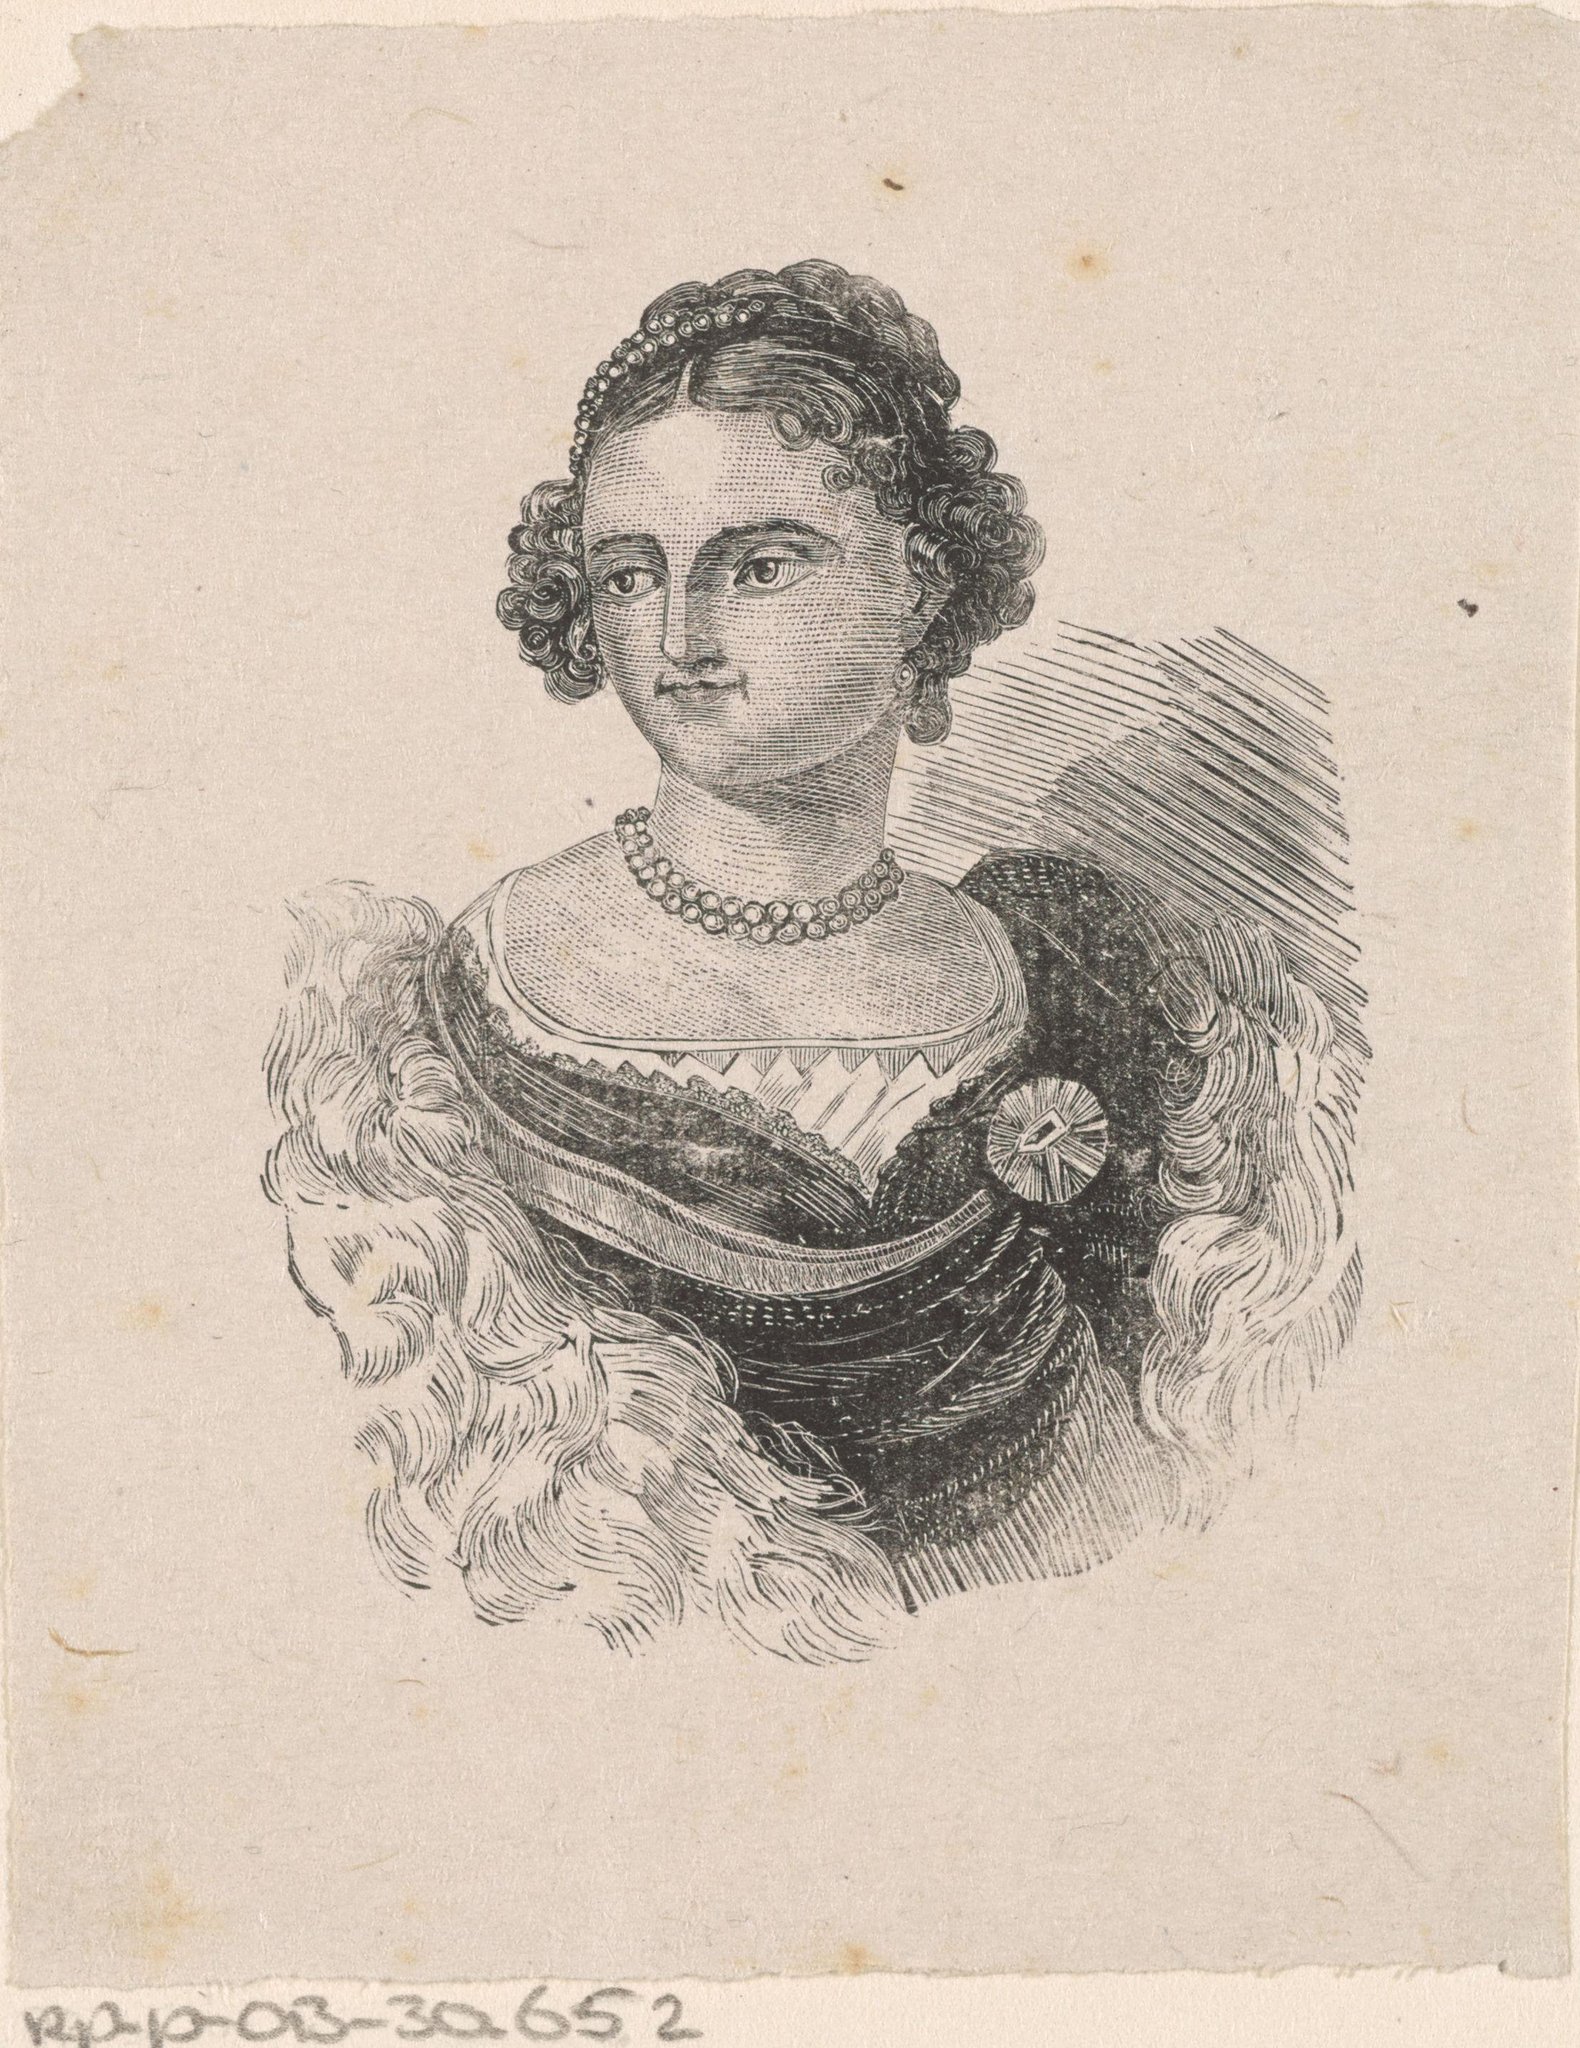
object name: print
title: Portret van een vrouw met een stola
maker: isaac weissenbruch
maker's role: print maker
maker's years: 1826-1912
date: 1836-1912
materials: paper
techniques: engraving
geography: netherlands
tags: anonymous historical person portrayed alone - bb - woman